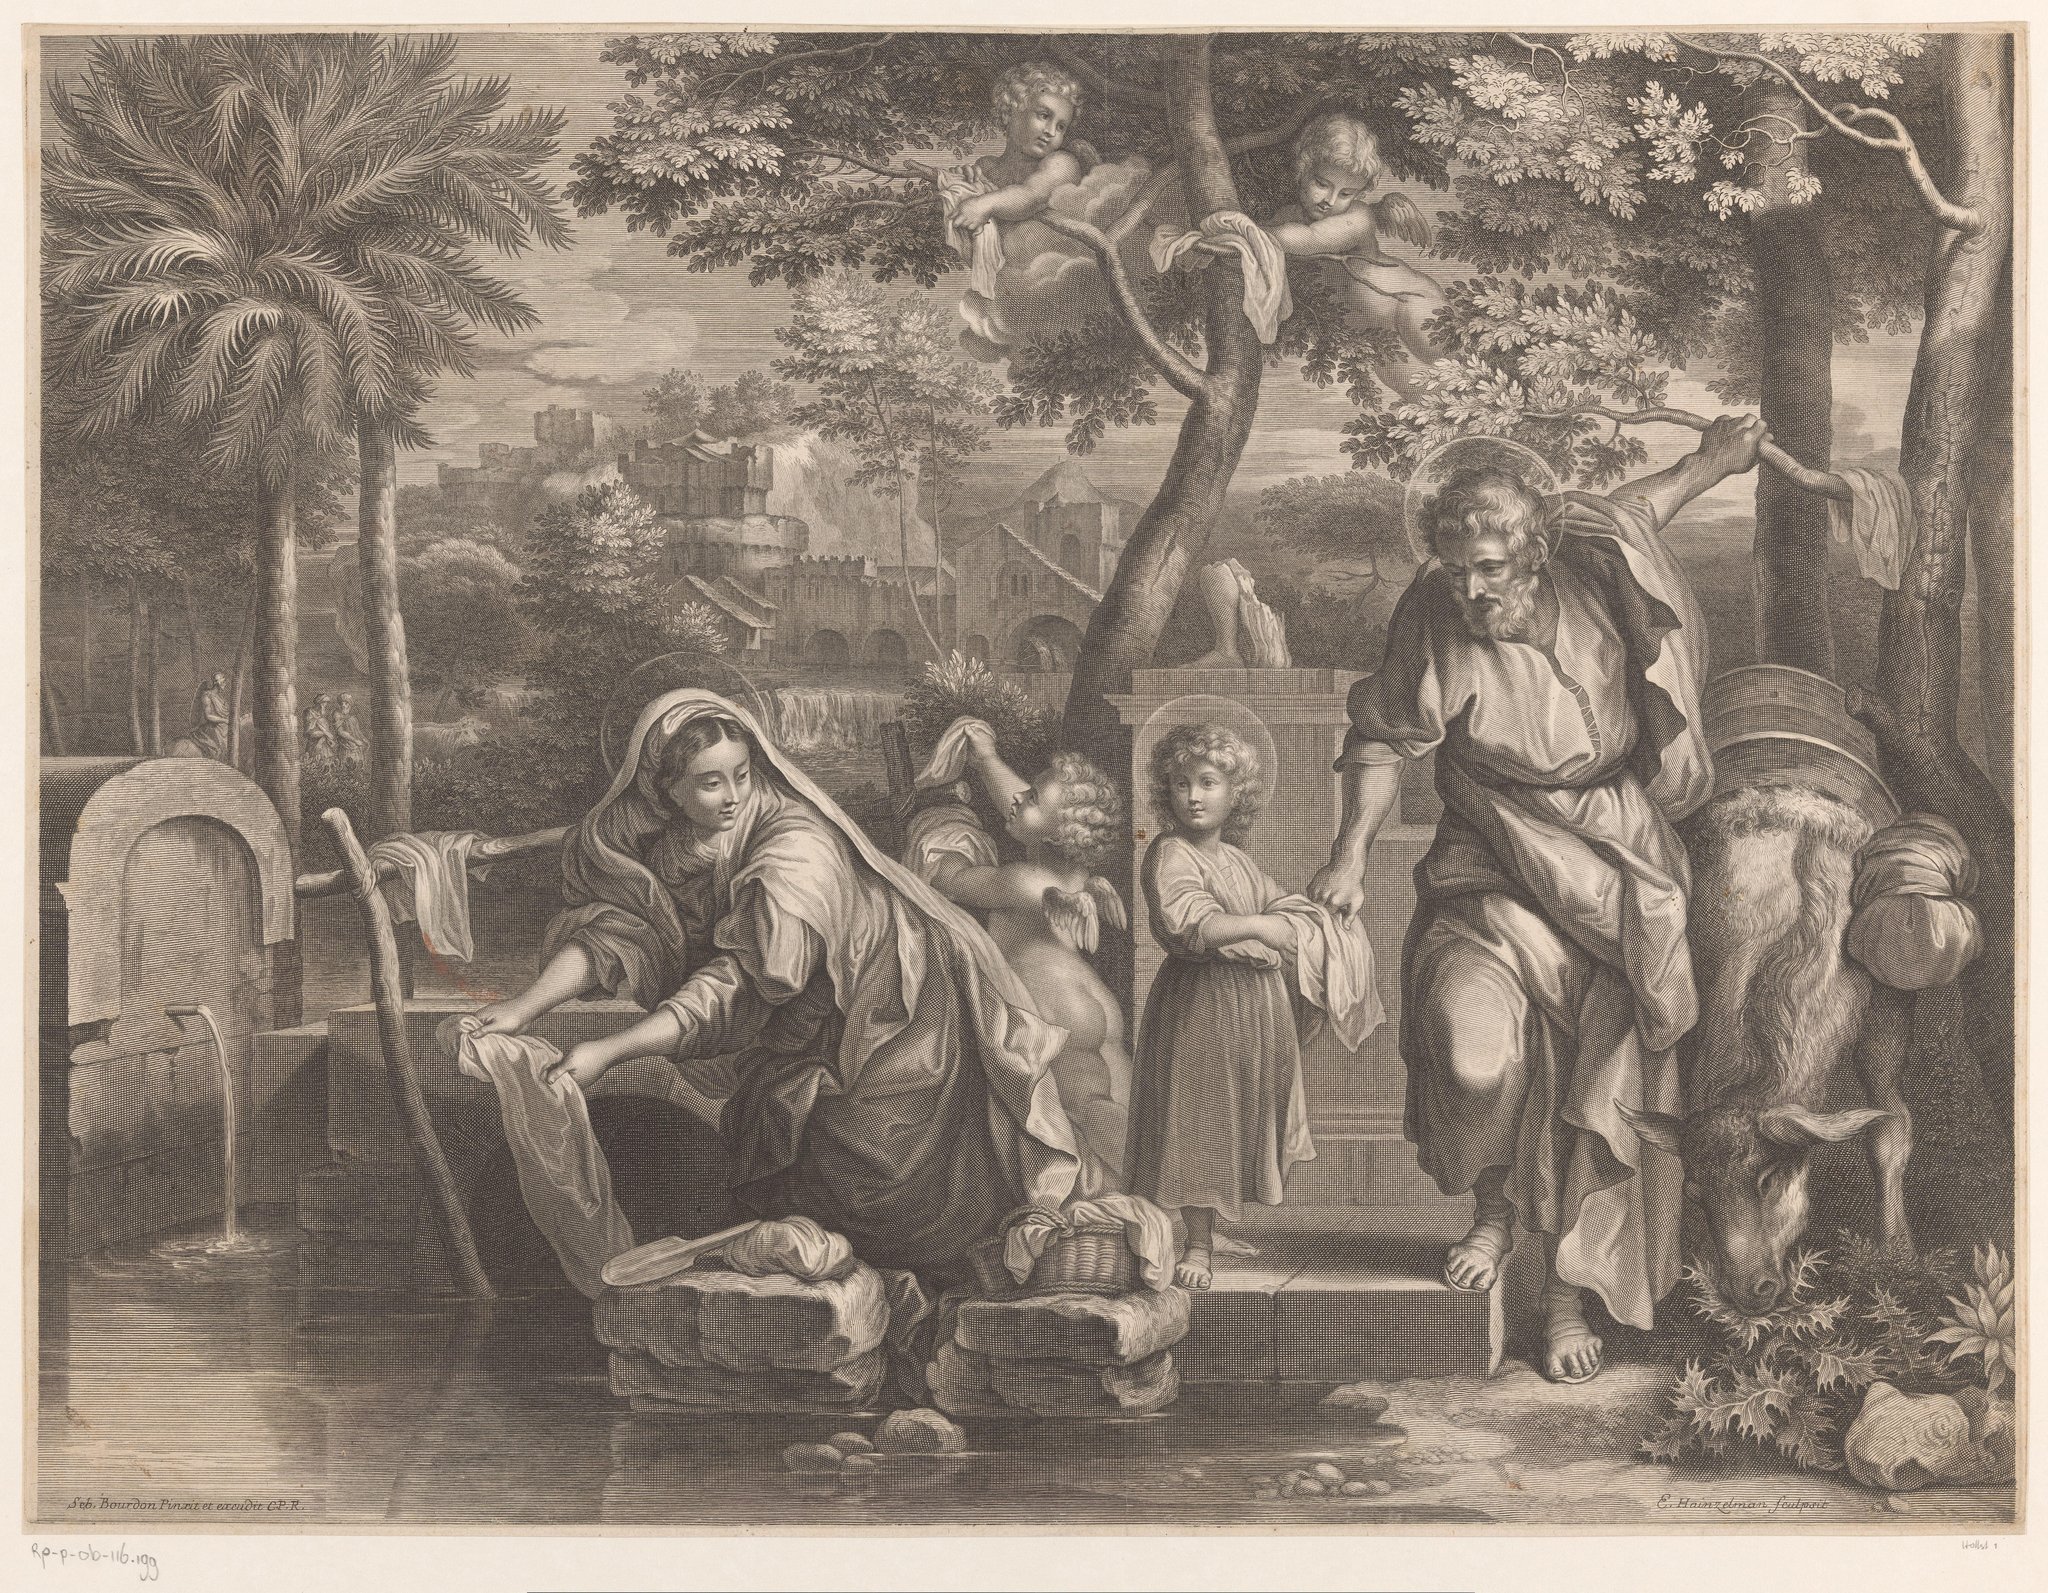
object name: print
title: Rest on the Flight into Egypt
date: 1650-1671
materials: paper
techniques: engraving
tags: rest on the flight into egypt (+ angel(s)), hanging the wash to dry